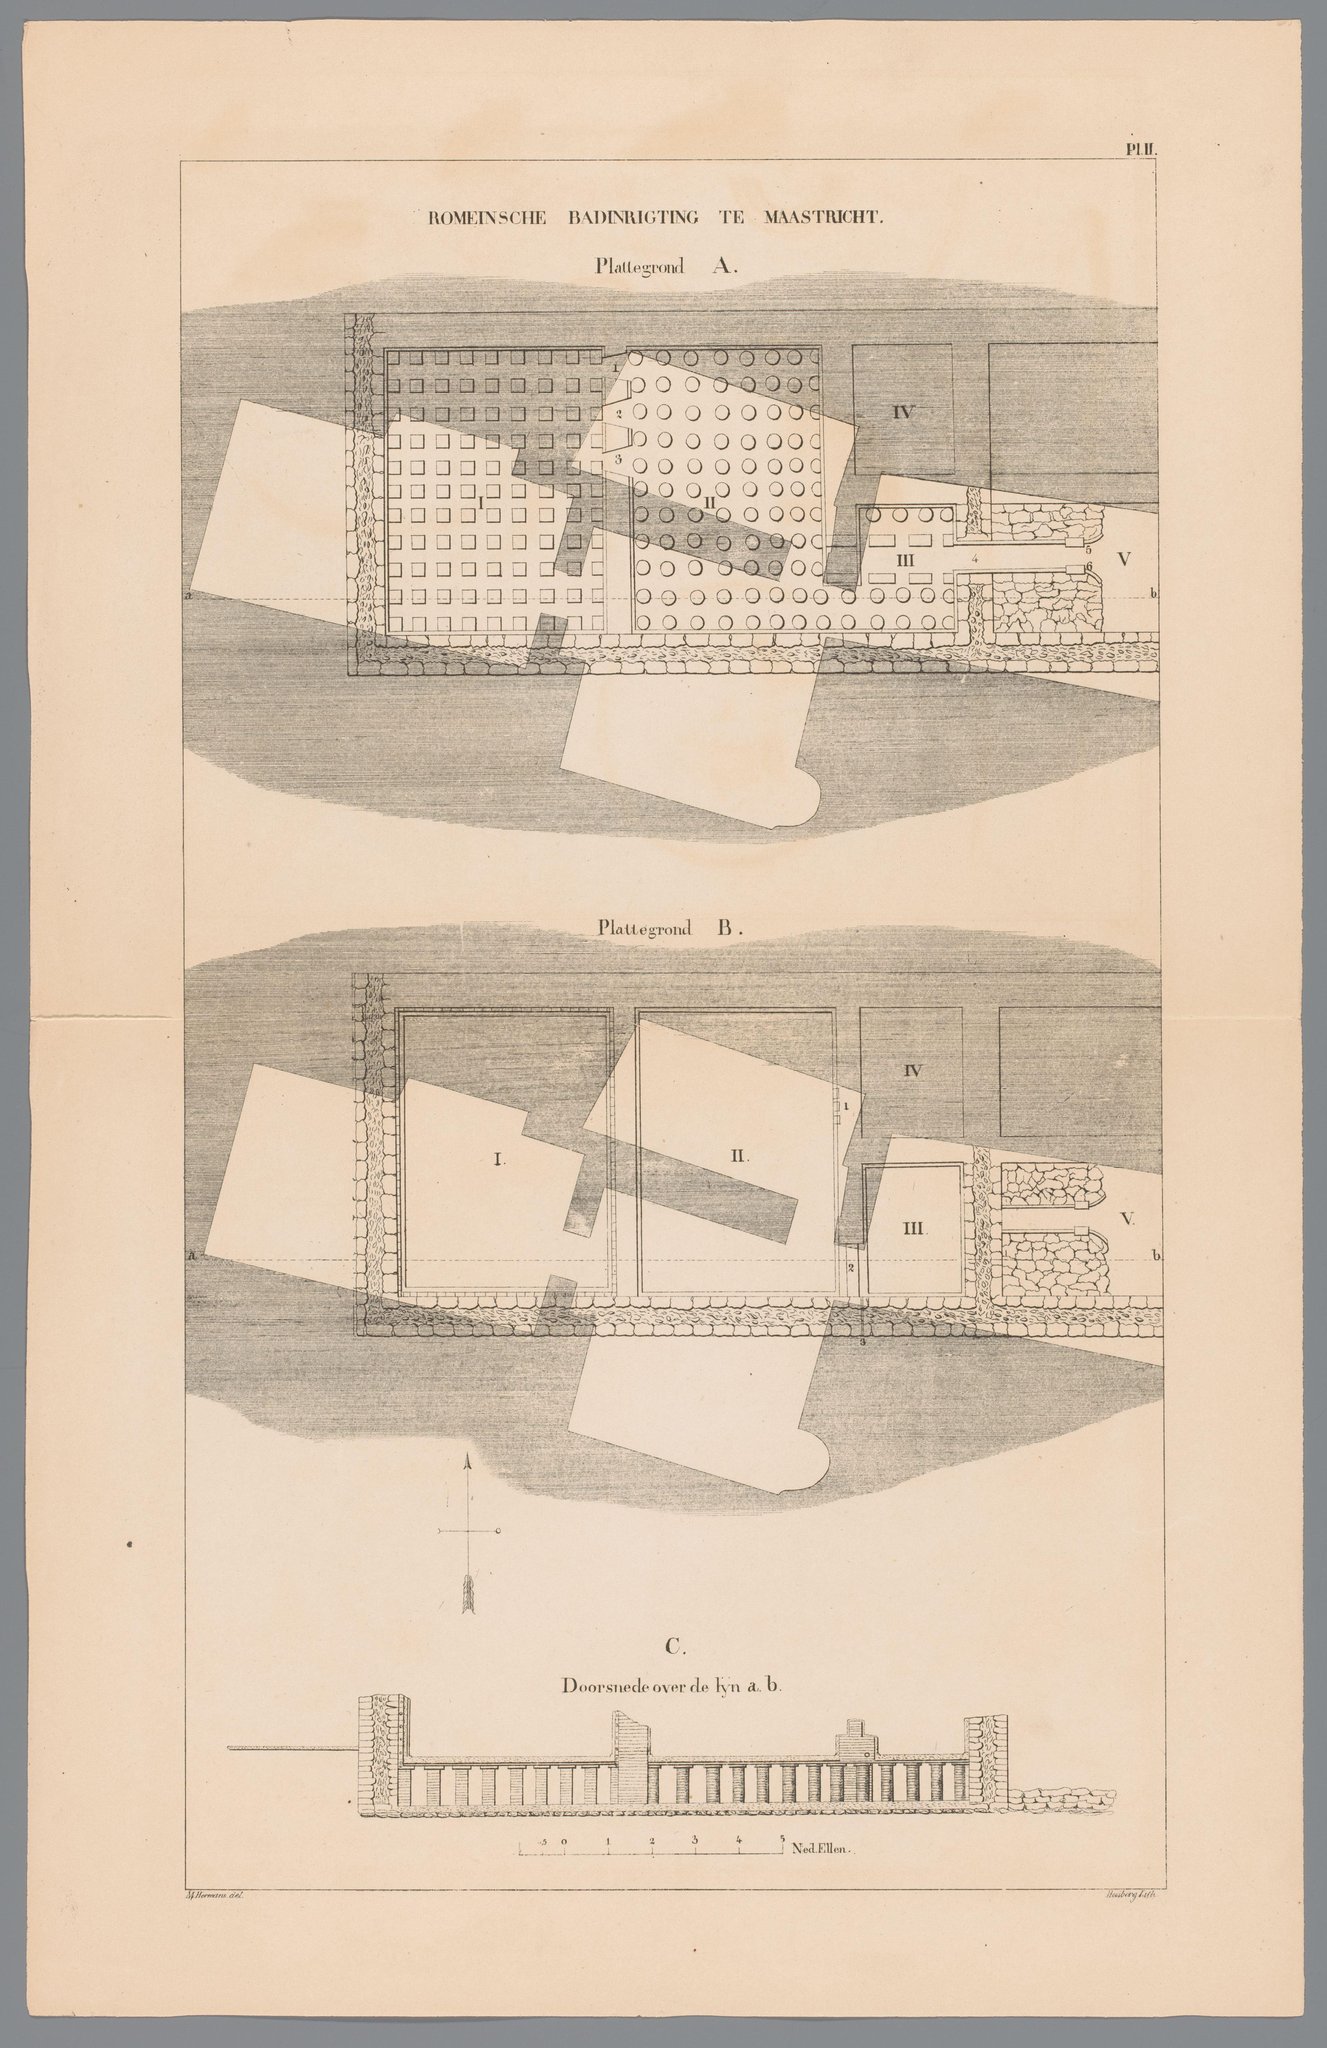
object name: print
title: Romeinsche Oudheden te Maastricht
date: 1843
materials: paper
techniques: lithograph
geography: maastricht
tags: public baths, rome (one of the four world empires), maastricht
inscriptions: collector's mark: Lugt 2228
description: Prent voor: Leemans, C. Romeinsche oudheden te Maastricht (...) Leiden, H. W. Hazenberg & Comp. 1843.